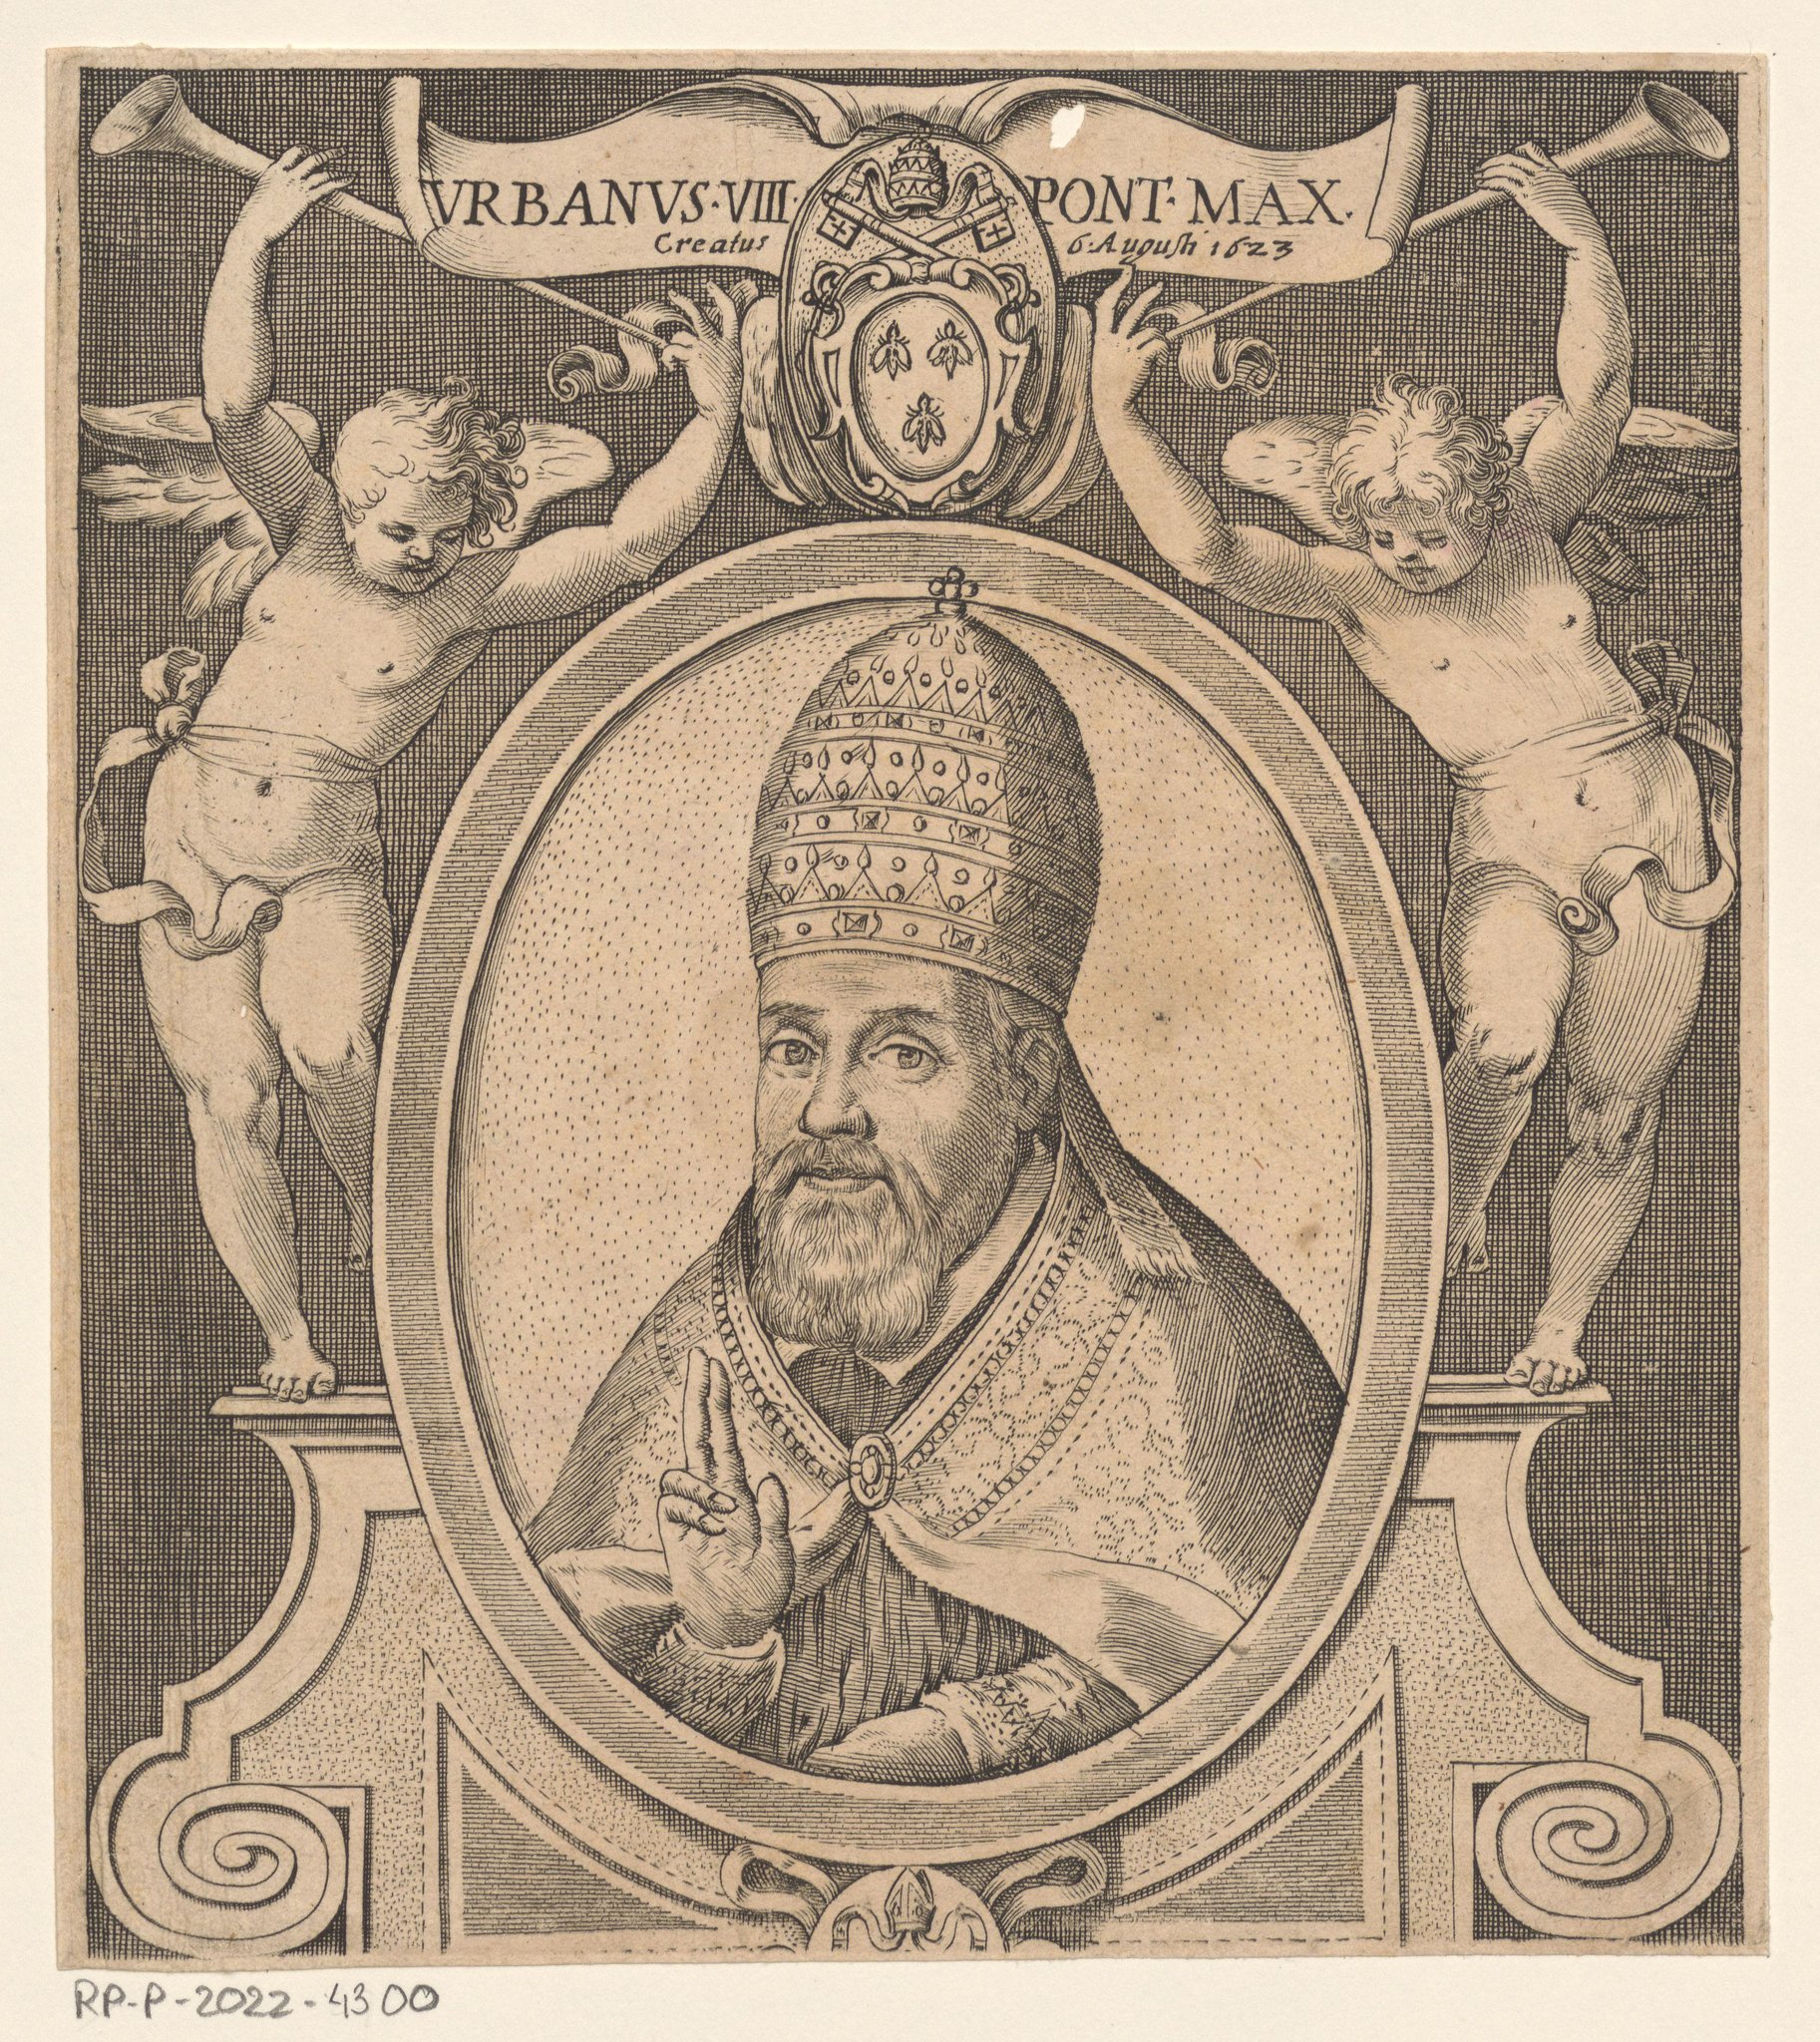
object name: print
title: Portret van paus Urbanus VIII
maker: Anonymous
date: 1623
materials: paper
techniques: engraving, etching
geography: italy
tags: clergyman, urbanus viii, historical persons, pope, cupids: 'amores', 'amoretti', 'putti', armorial bearing, heraldry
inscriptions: collector's mark: Lugt 2228